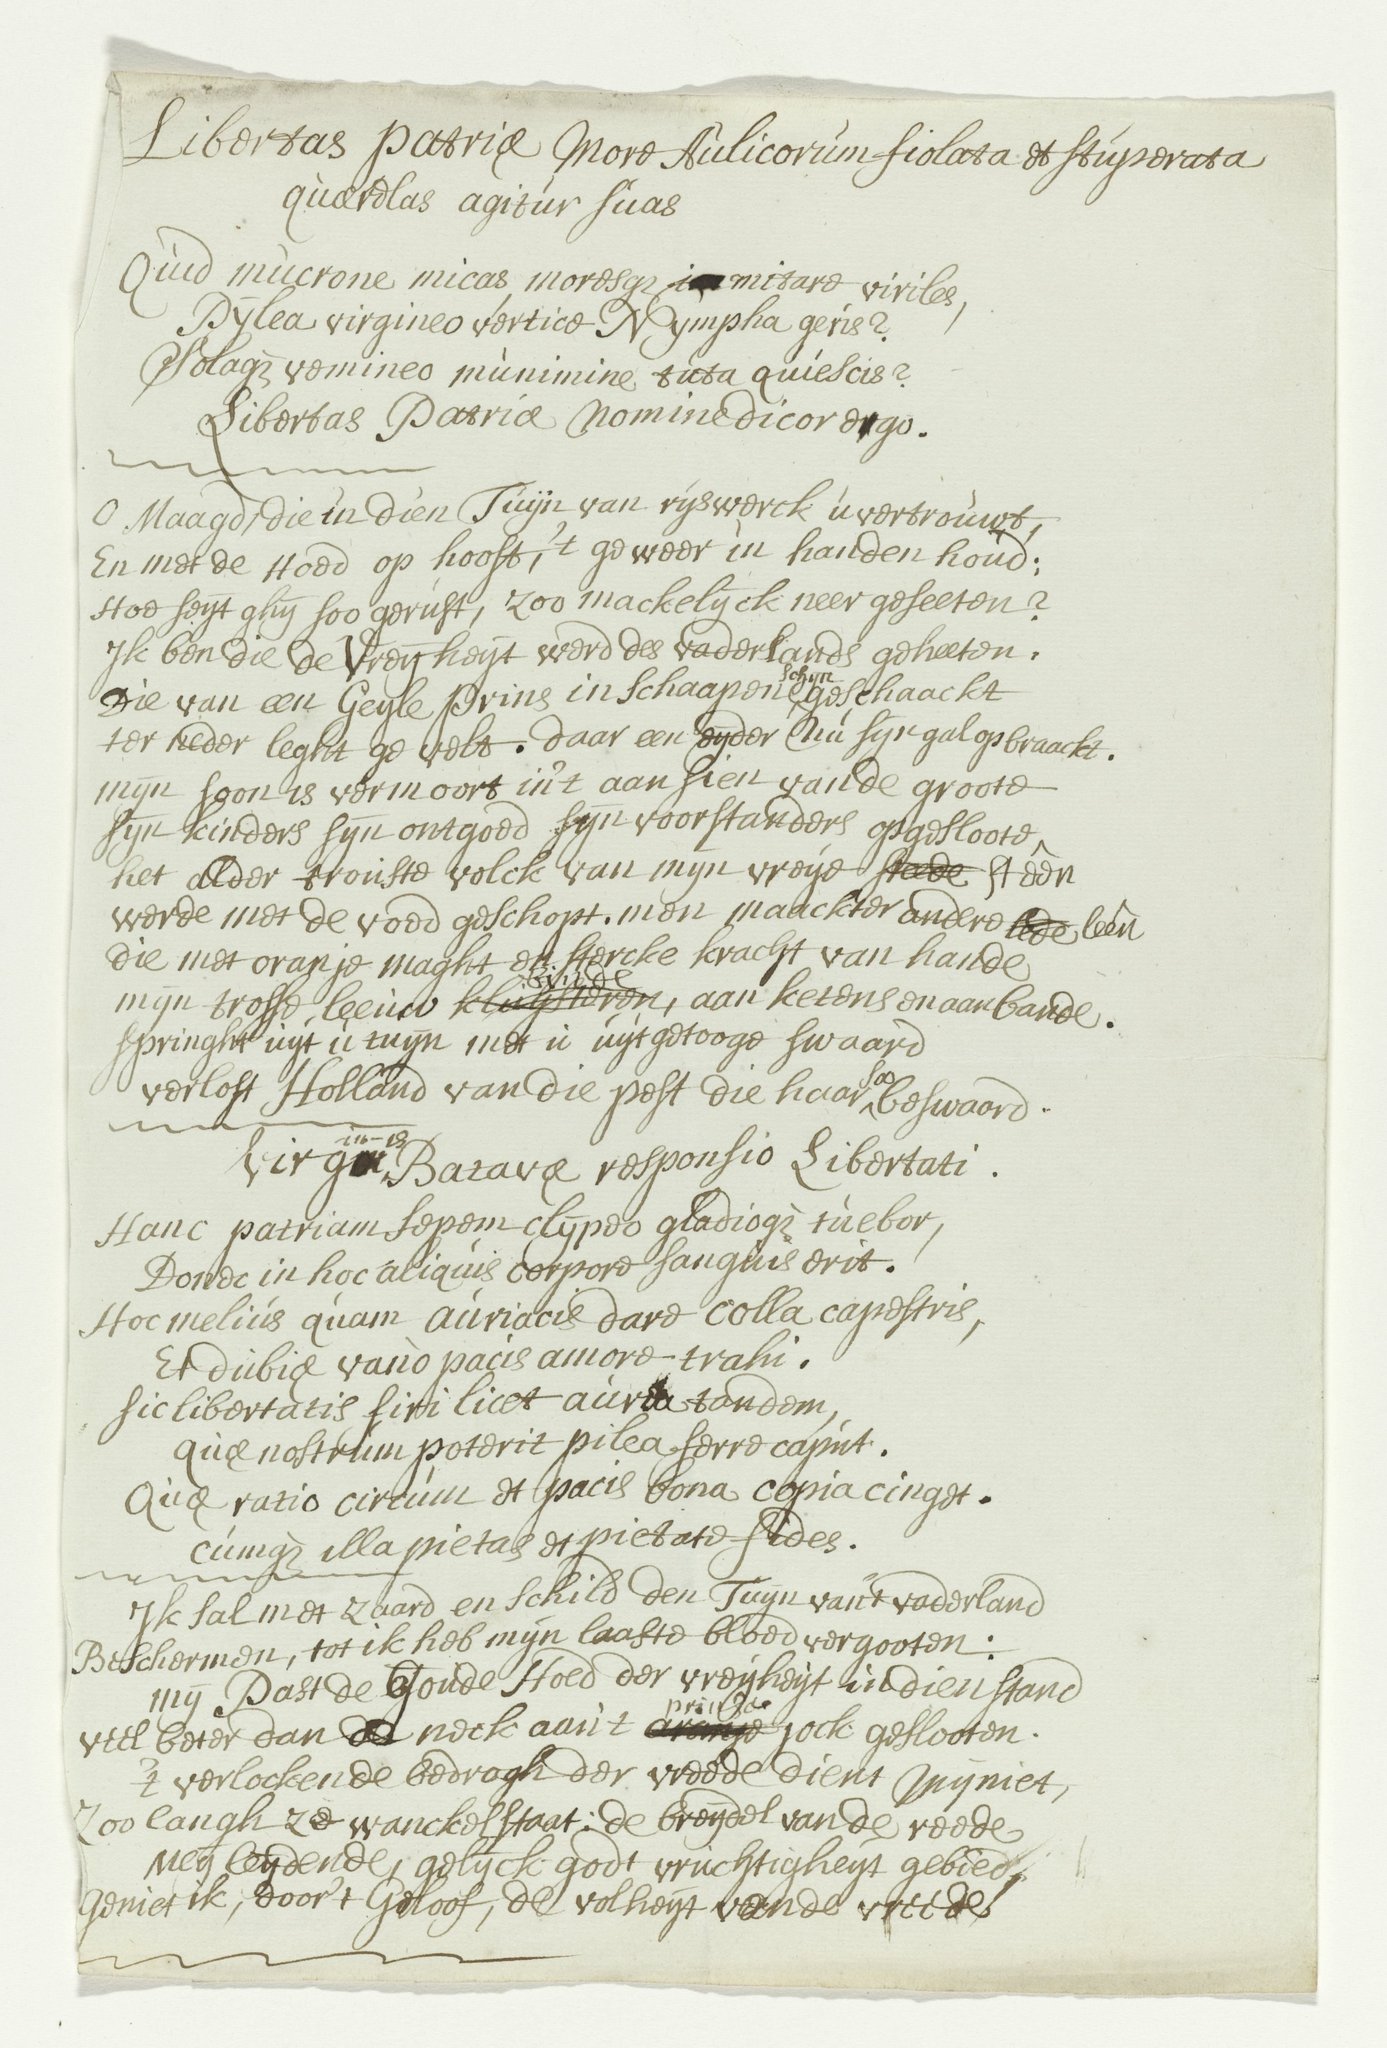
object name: manuscript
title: Toelichting bij de Triomf-poort van prins Maurits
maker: Anonymous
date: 1710-1720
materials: paper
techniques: pen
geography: netherlands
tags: the hague, johan van oldenbarnevelt, maurice (prince of orange)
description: Bladzijde met geschreven toelichting op de tekening met triomfpoort voor prins Maurits. Behorende bij serie aquarellen in boek.